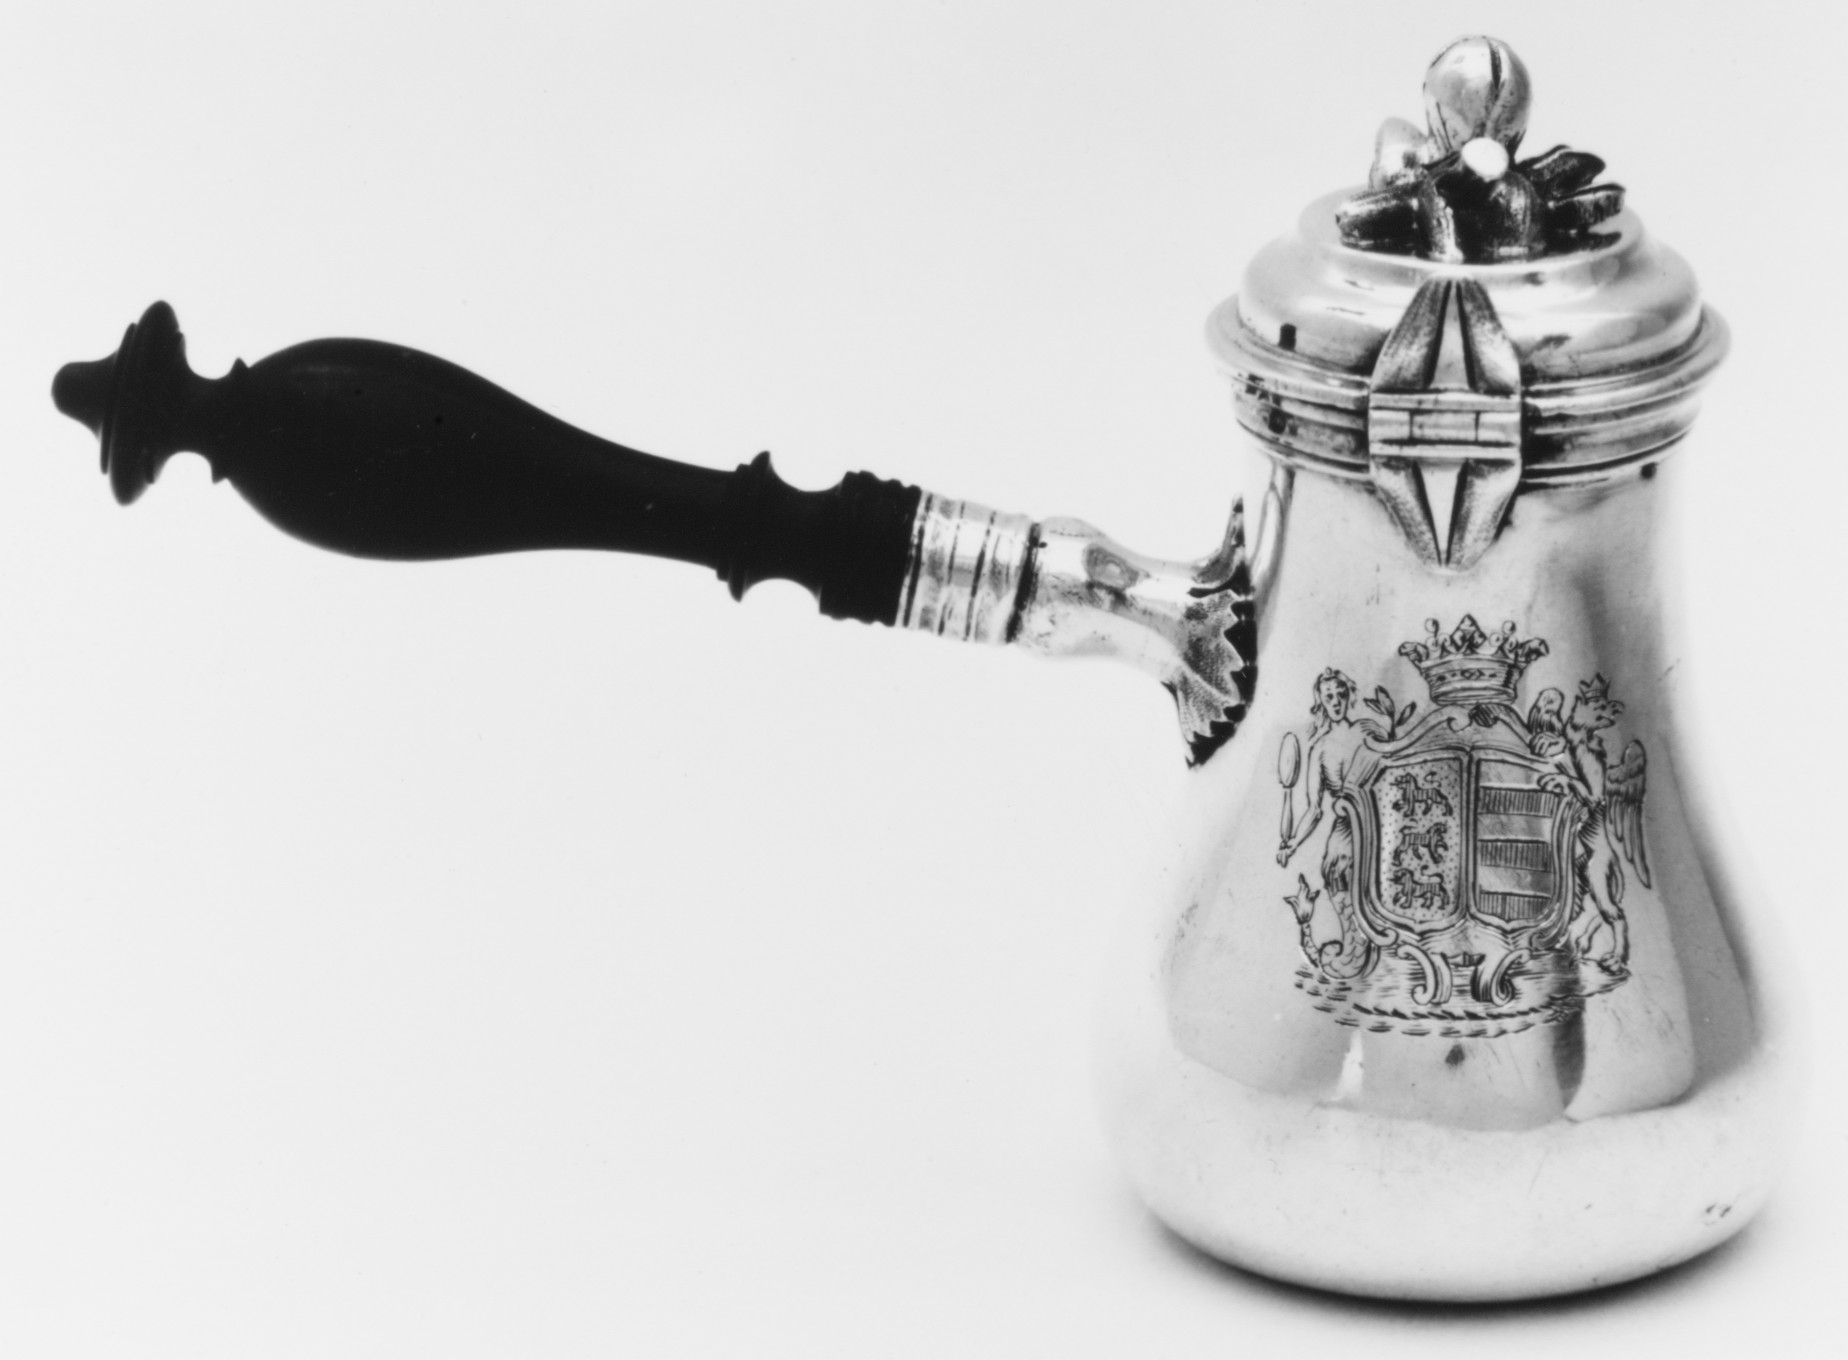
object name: coffeepot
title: Miniature coffeepot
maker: antoine bouiller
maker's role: maker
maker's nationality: french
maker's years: 1745-1836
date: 1777-1778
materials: silver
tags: coat of arms